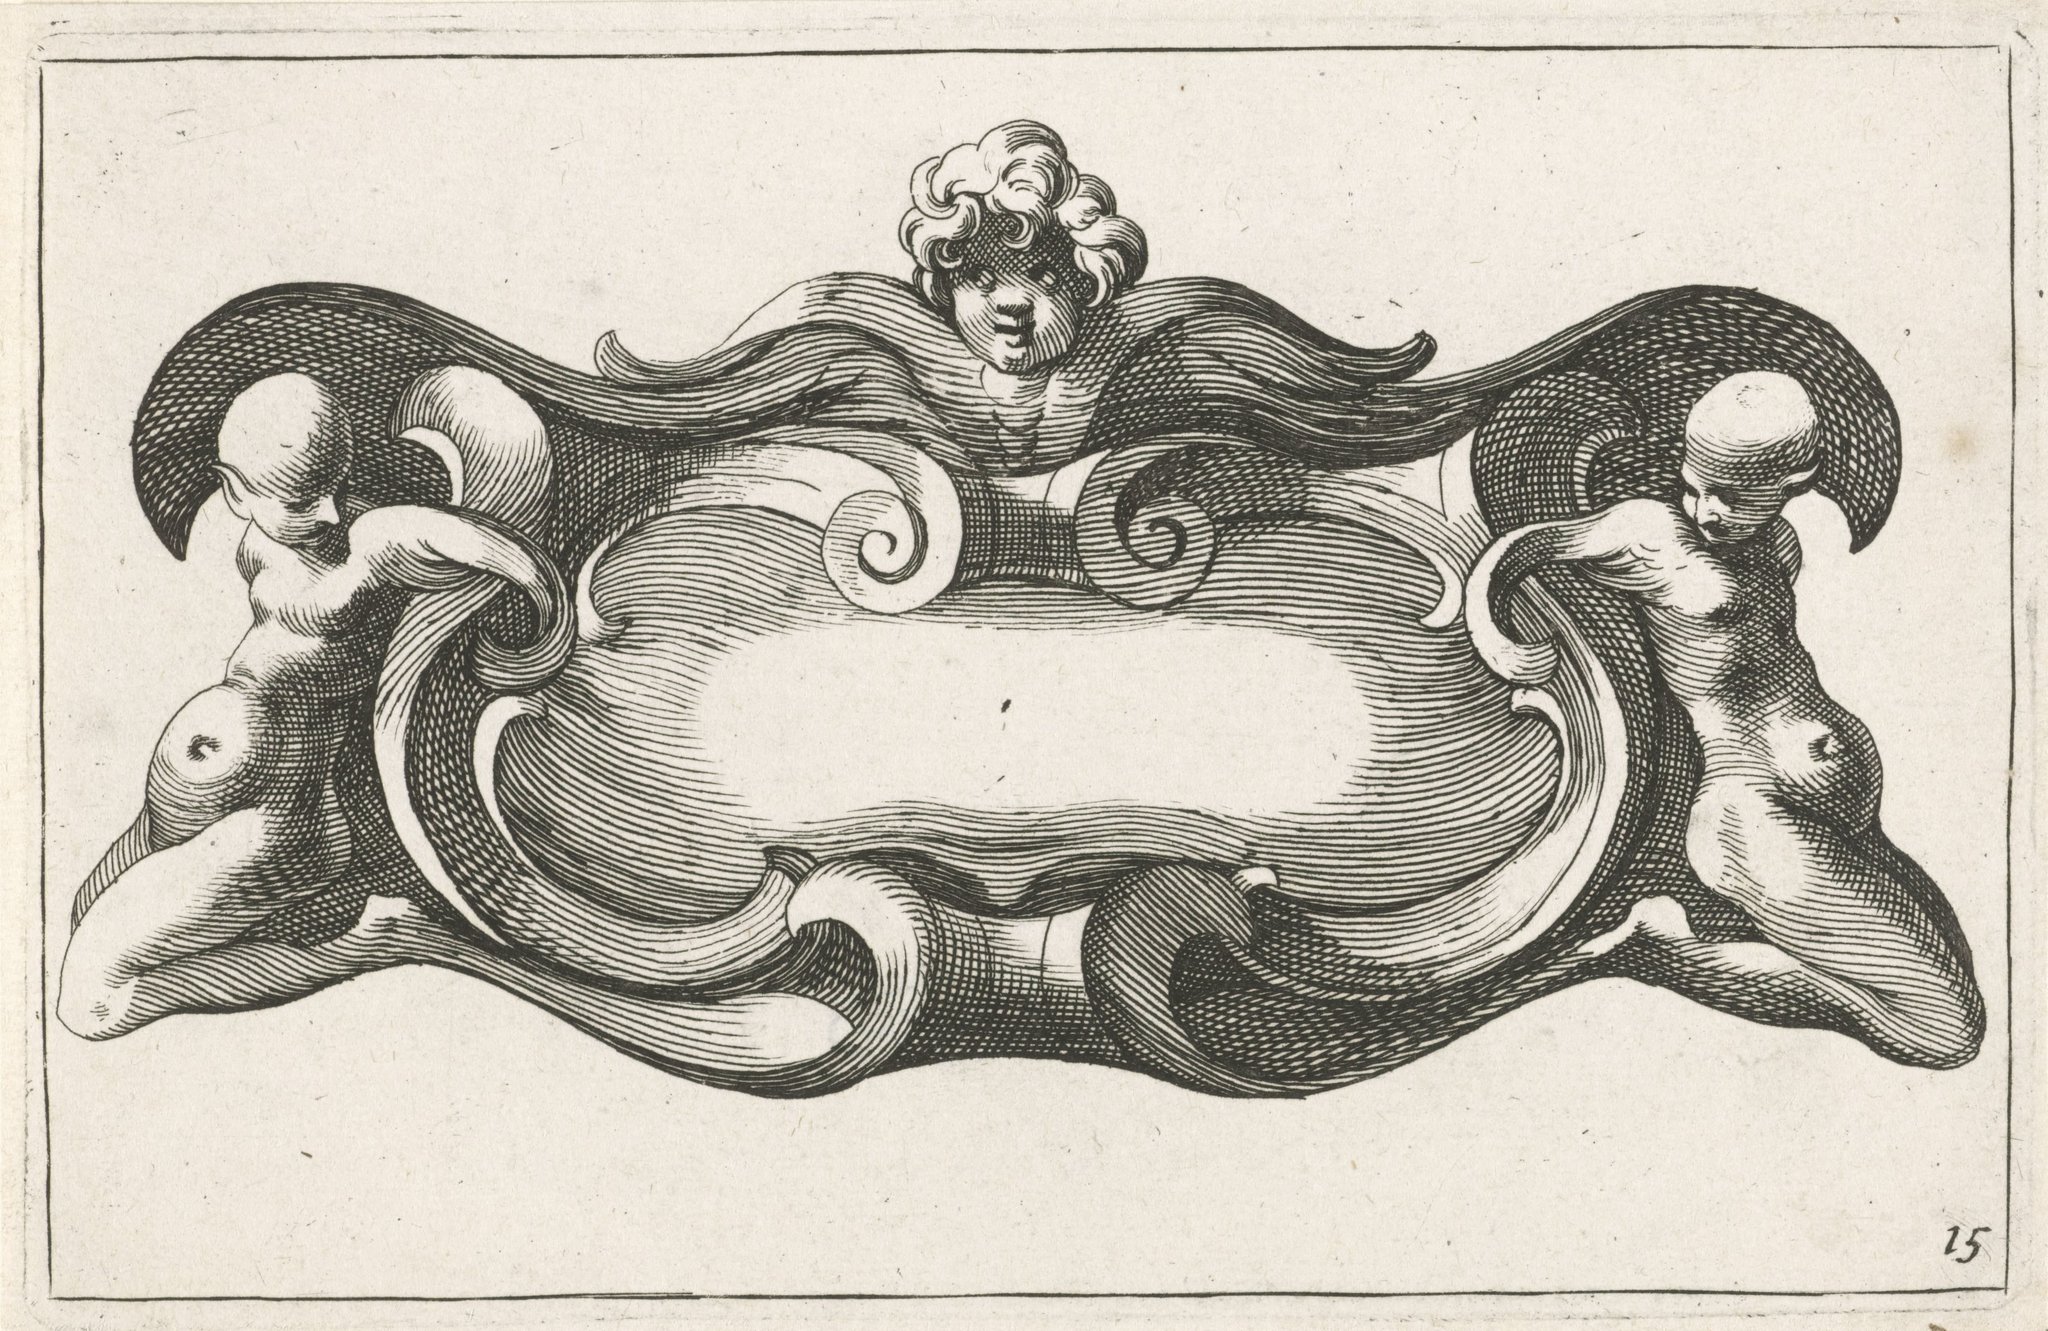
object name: ornament print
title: Differents Conpartimens et Chapiteaux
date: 1657-1685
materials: paper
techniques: engraving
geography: paris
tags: cherubs, i.e. children's heads with wings